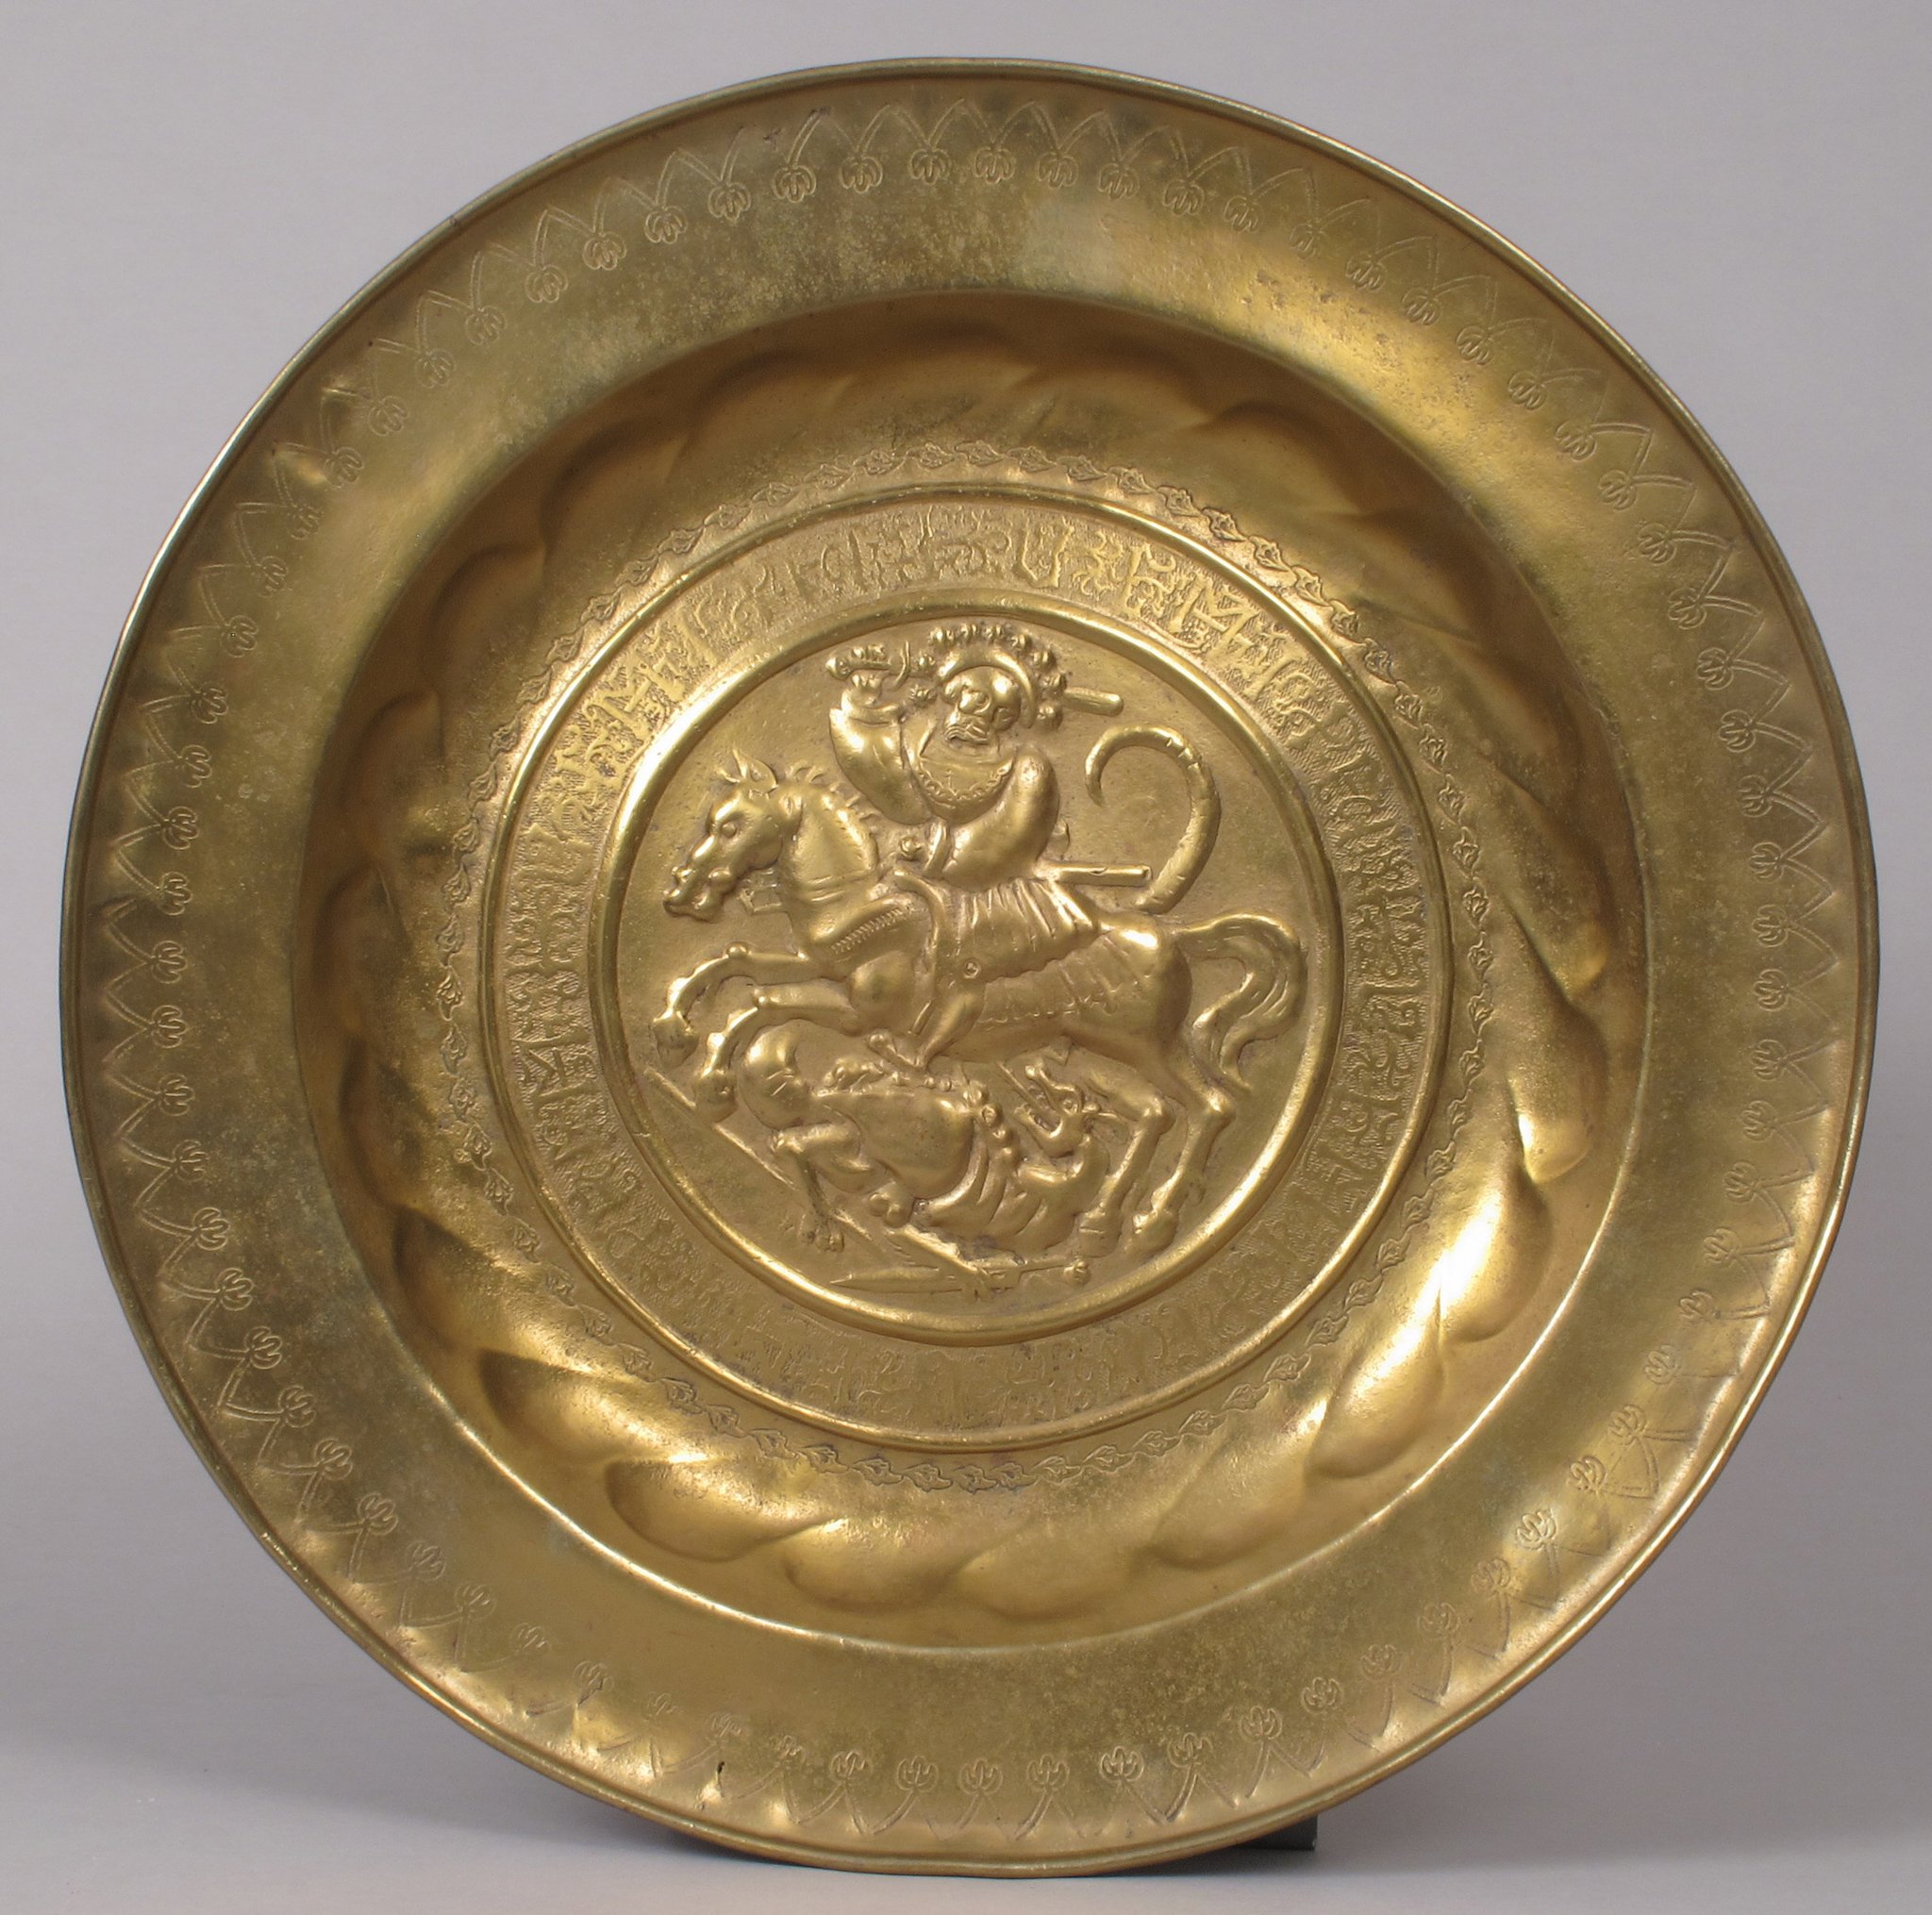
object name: dish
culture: german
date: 1501-1533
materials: brass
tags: human figures,horses